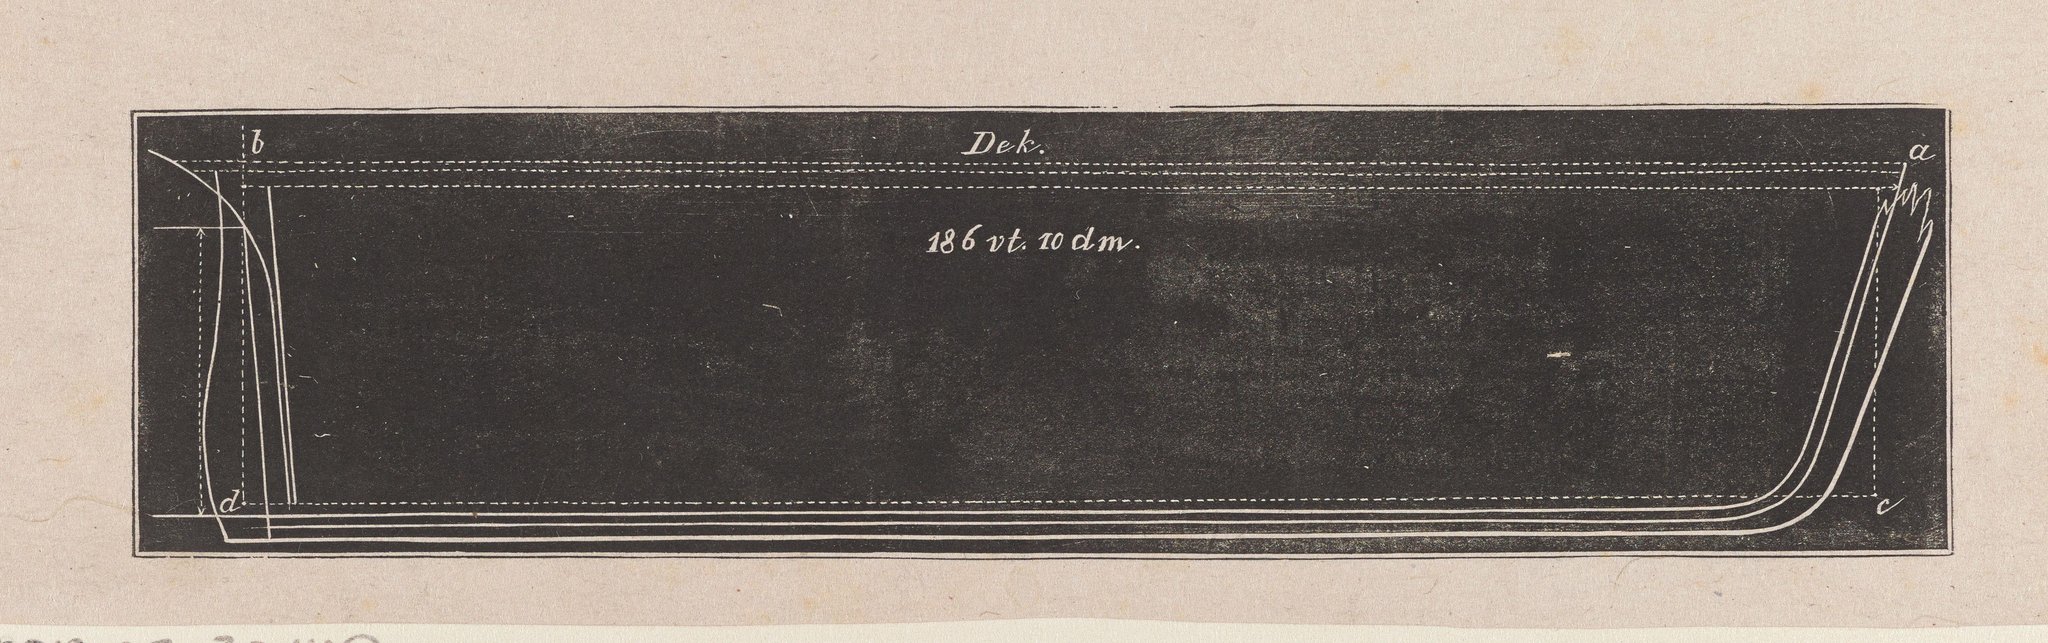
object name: print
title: Doorsnede van een schip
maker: isaac weissenbruch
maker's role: print maker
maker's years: 1826-1912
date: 1836-1912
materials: paper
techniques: engraving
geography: netherlands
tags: ships (in general)